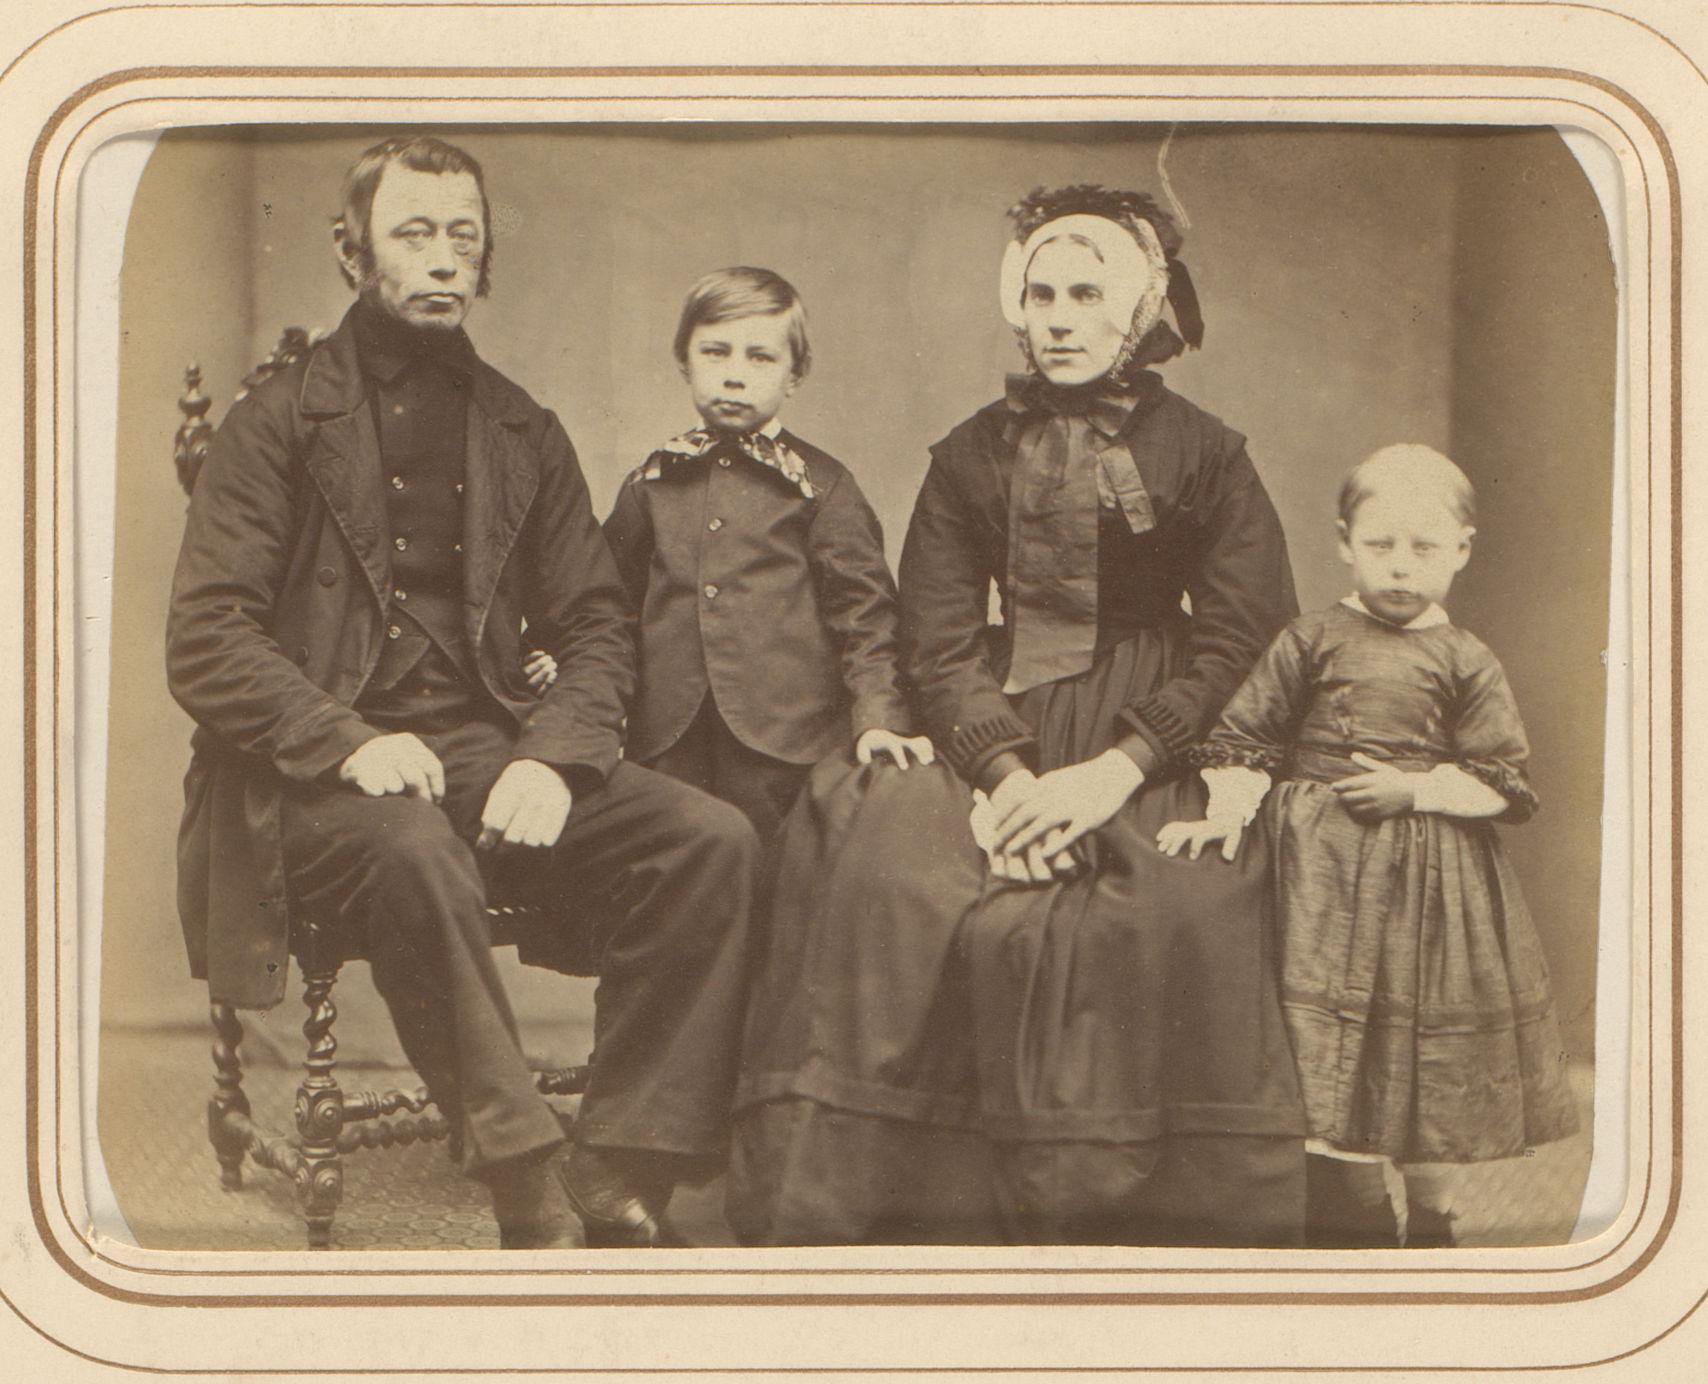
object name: cabinet photograph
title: Familieportret van een man, vrouw en zoon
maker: Anonymous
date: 1865-1890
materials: cardboard, photographic support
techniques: albumen print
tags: parents with their children, family life